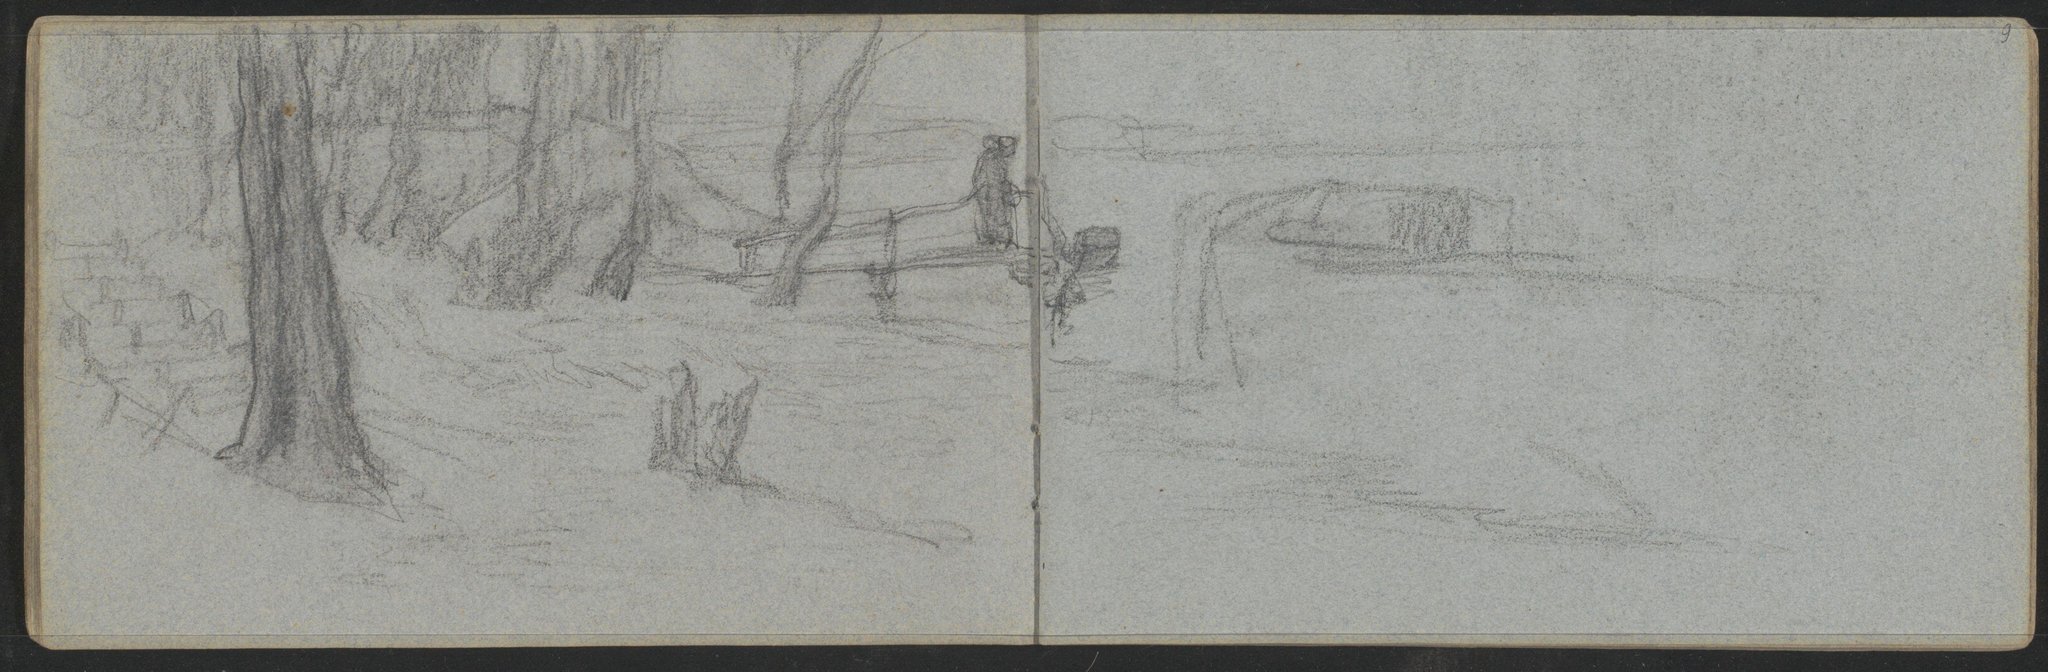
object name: sketchbook leaf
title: Figuur op een vlonder aan een waterkant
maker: matthijs maris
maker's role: draughtsman, painter, print maker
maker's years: 1839-1917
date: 1849-1917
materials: paper, pencil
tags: forest, wood, landscapes with waters, waterscapes, seascapes (in the temperate zone) (+ landscape with figures, staffage)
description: Langs de waterkant een bos. Blad 8 verso en 9 recto uit een schetsboek met 35 bladen.